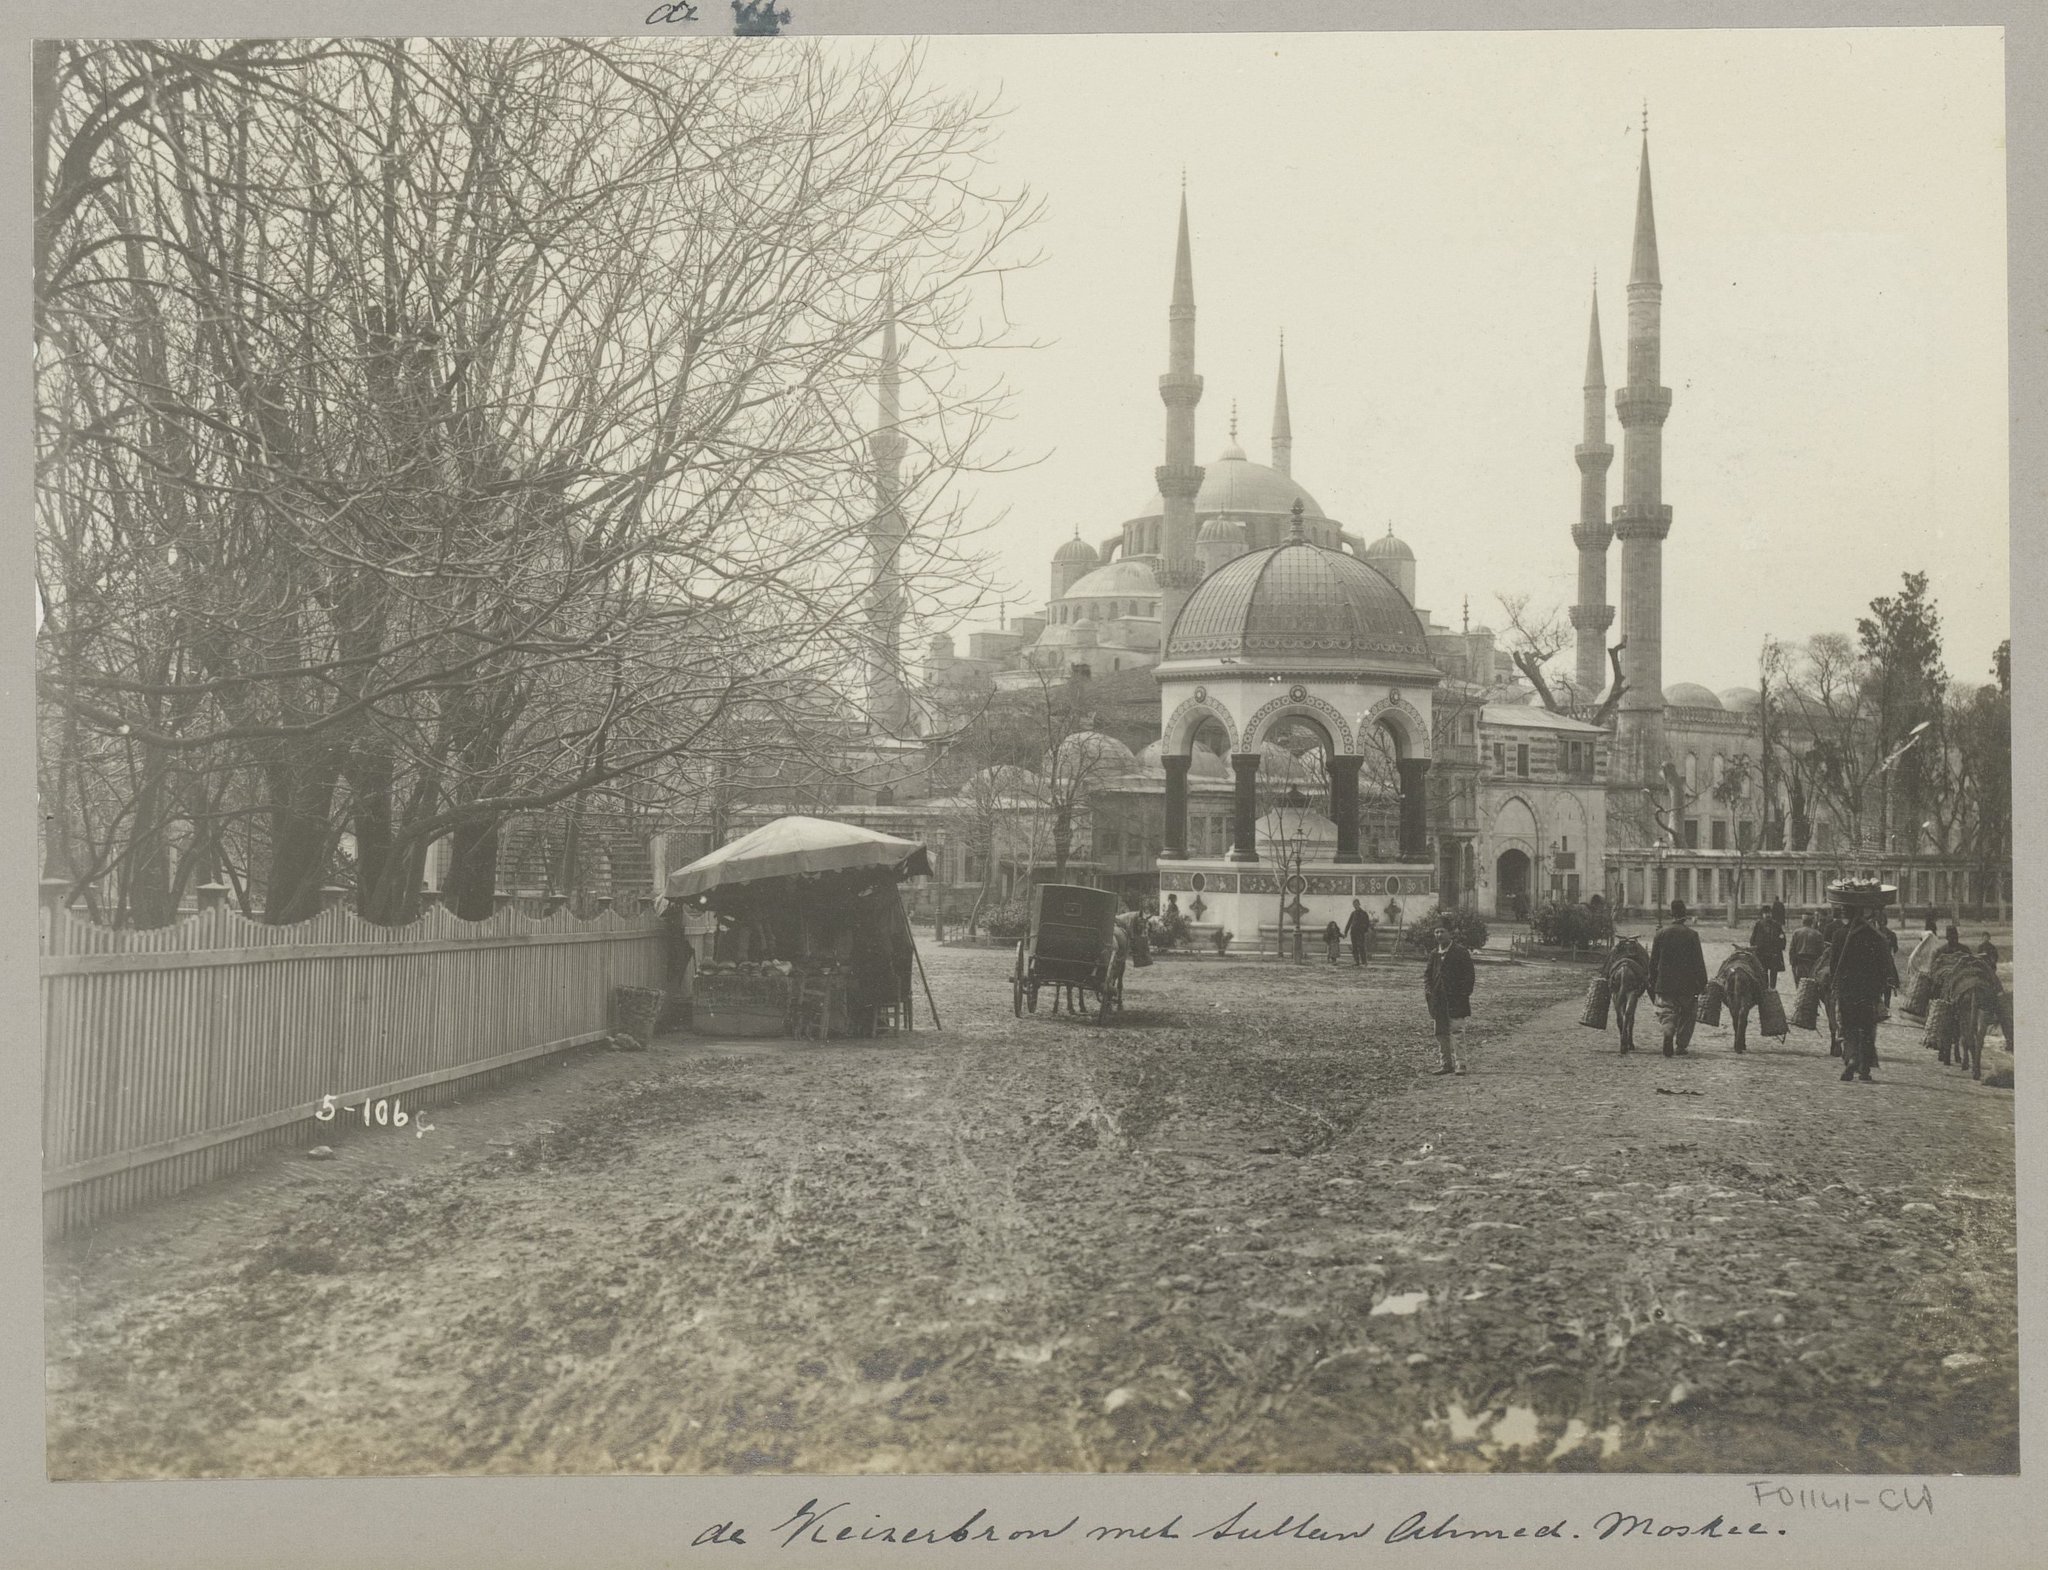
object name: photograph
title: Gezicht op de Sultan Ahmetmoskee en de Keizerbron in Istanbul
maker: Anonymous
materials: photographic support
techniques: gelatin silver print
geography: istanbul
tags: temple, shrine ~ islam, mohammedanism, ornamental fountain (+ city(-scape) with figures, staffage)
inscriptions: number: ‘5 - 106c’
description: Onderdeel van Fotoalbum van een reis door Zuid-Europa en het Midden-Oosten.